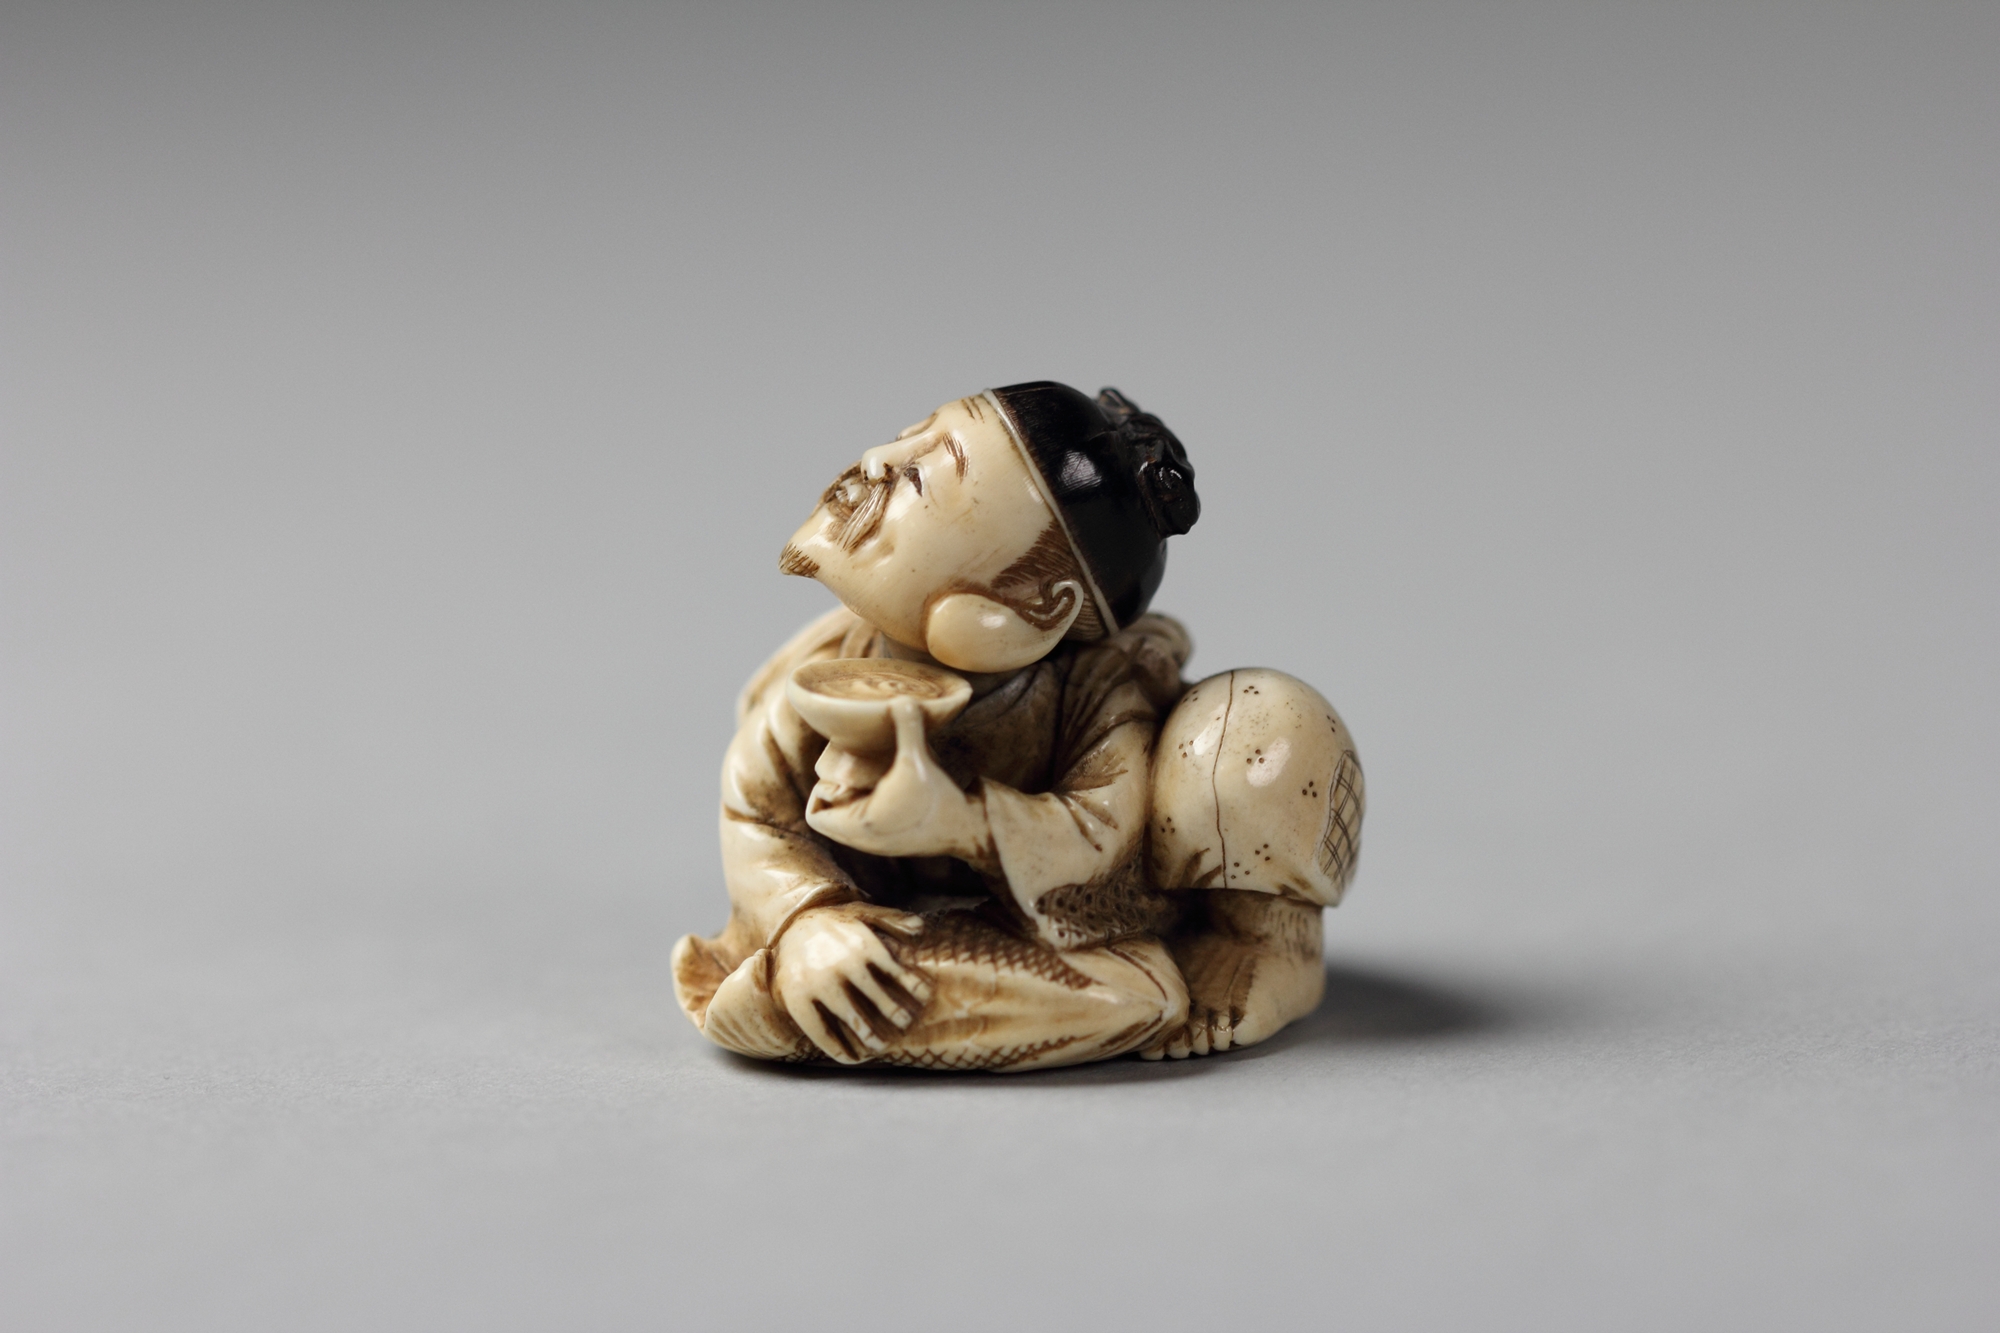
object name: netsuke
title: Netsuke of Ebisu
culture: japanese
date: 1701-1800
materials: ivory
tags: men